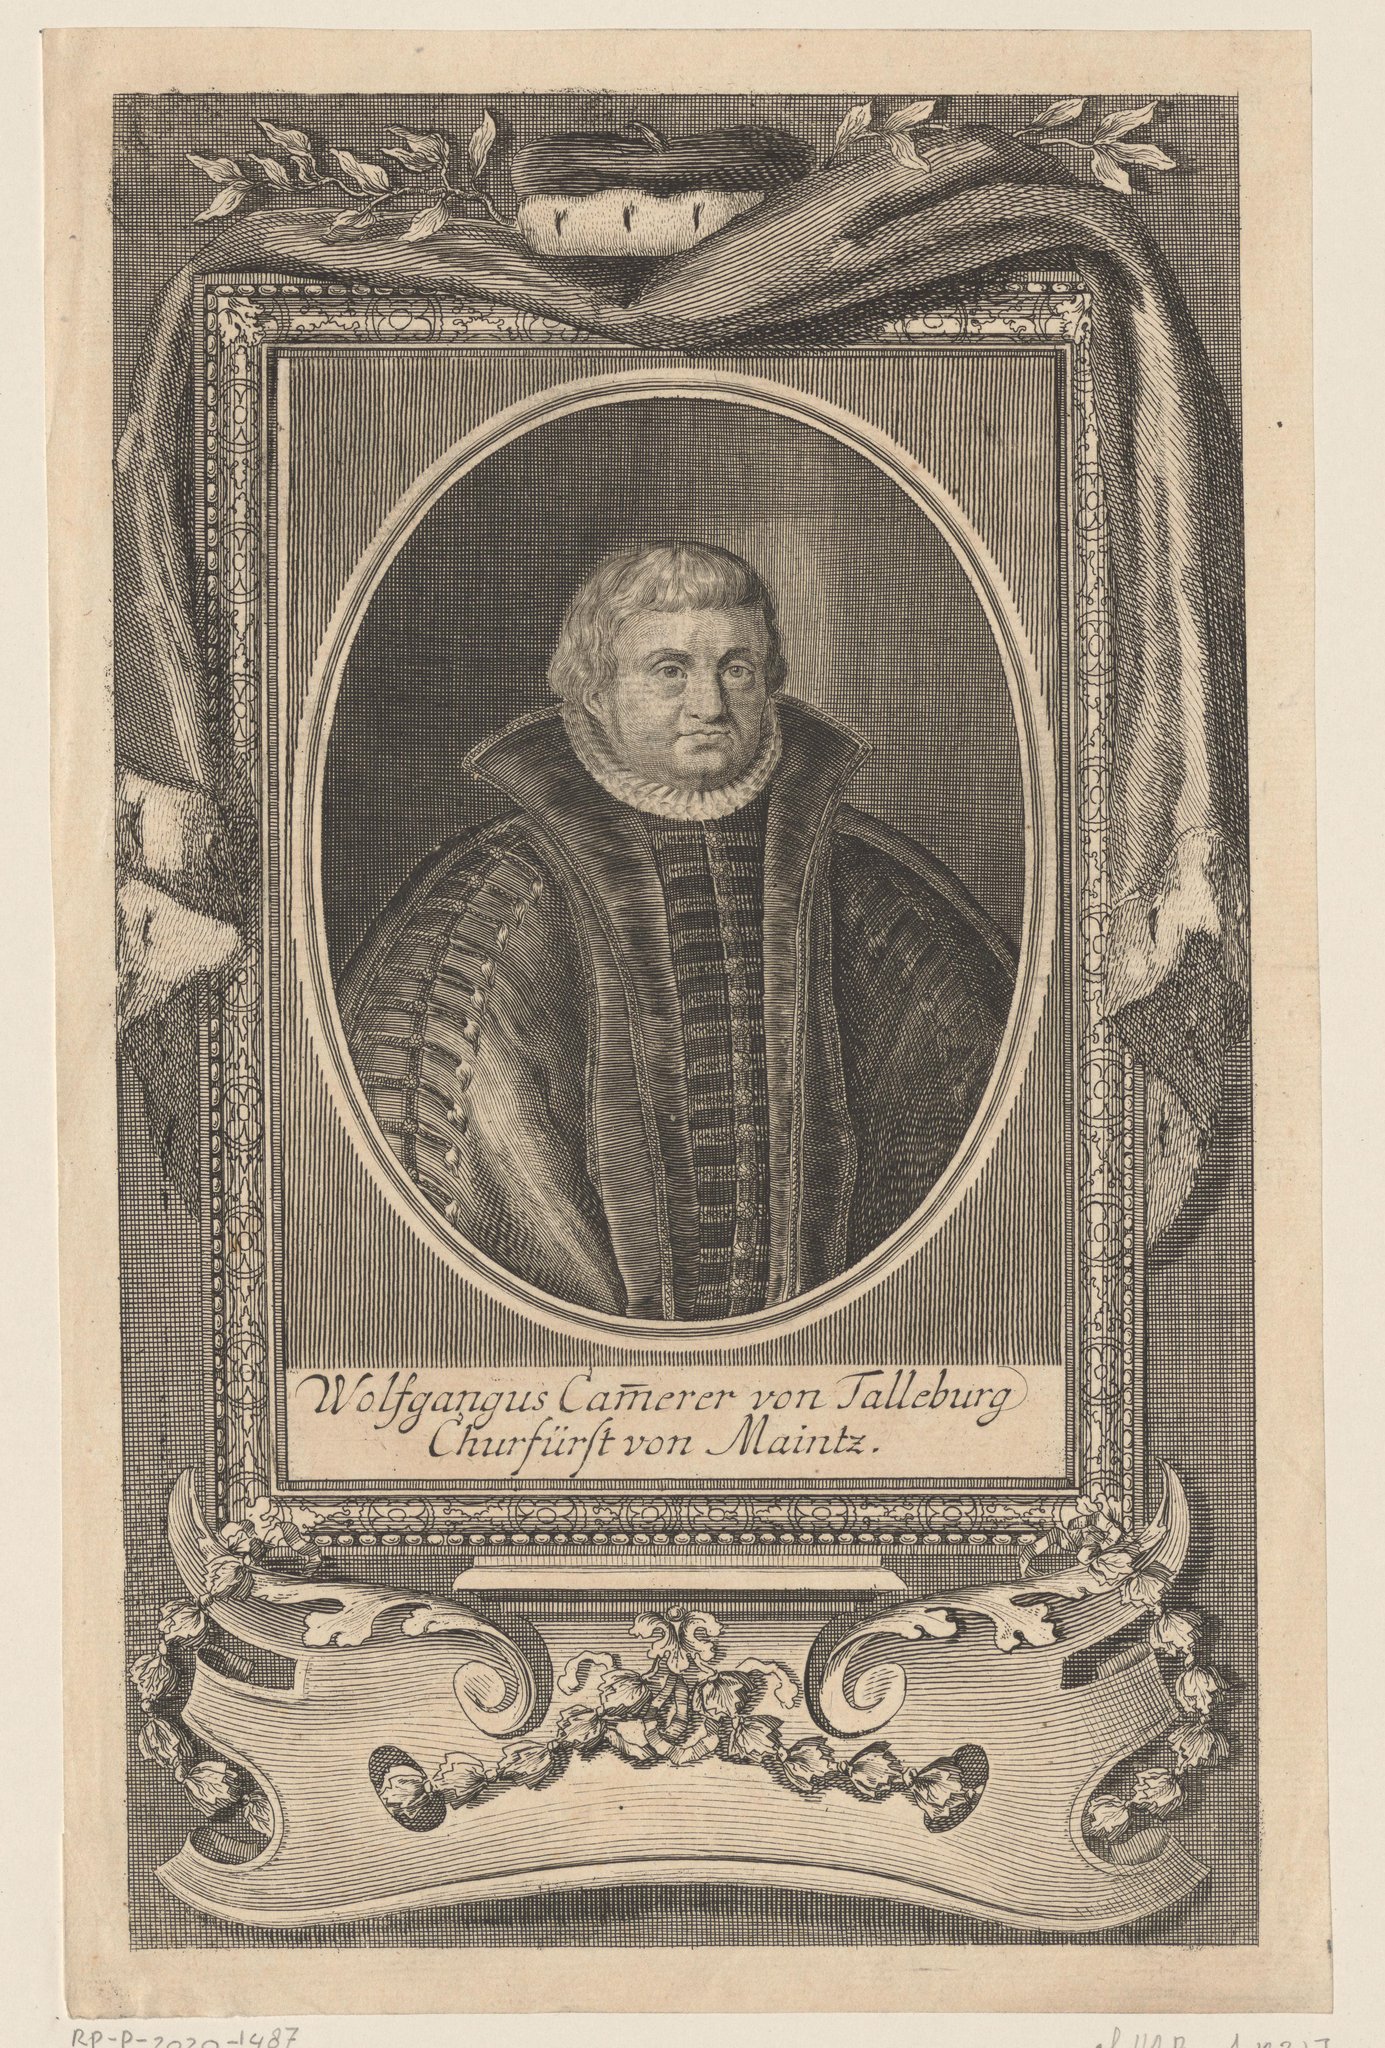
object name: print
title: Portret van Wolfgang von Dalberg, aartsbisschop en keurvorst van Mainz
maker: Anonymous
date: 1722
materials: paper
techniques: engraving, etching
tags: archbishop, bishop, etc. (roman catholic), historical persons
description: Prent mogelijk gebruikt in: Khevenhüller, Franz Christoph. Conterfet Kupferstich (so viel man bekommen können) deren jenigen vornehmen Ministren un hohen Officiern (...). Leipzig: Moritz Georg Weidmann, 1722, dl. 2.